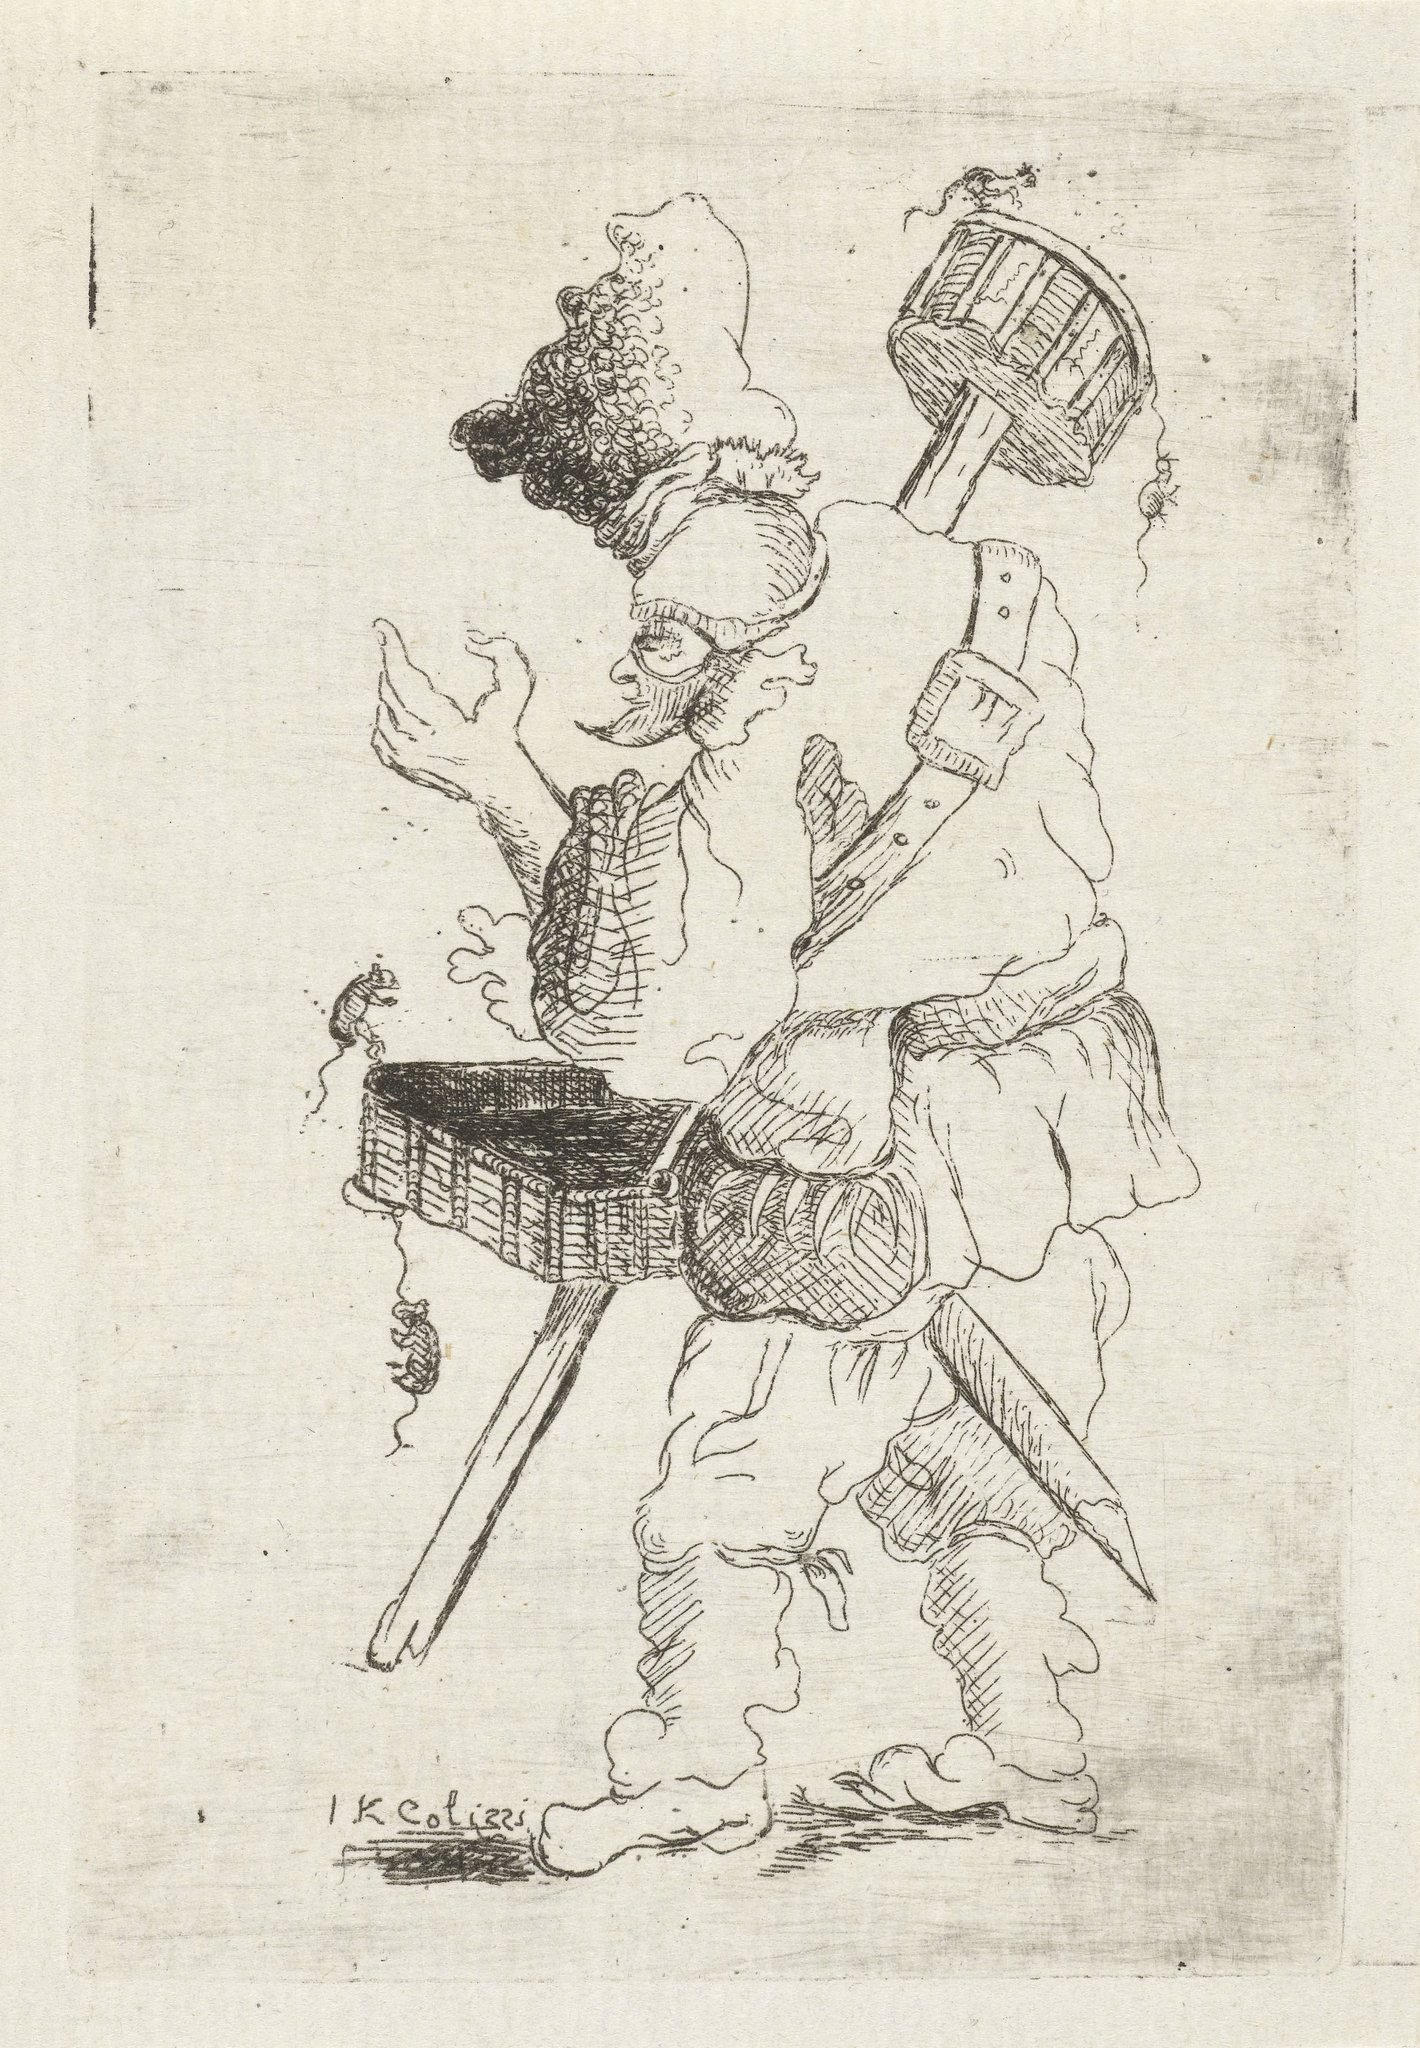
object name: print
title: Rattengifverkoper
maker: johan antoni kauclitz colizzi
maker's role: print maker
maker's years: 1742-1808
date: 1774-1808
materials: paper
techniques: etching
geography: netherlands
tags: rat exterminator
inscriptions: collector's mark: Lugt 2228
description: Parodie op een prent van Rembrandt met een rattengifverkoper die voor een huis zijn waar aanbiedt.